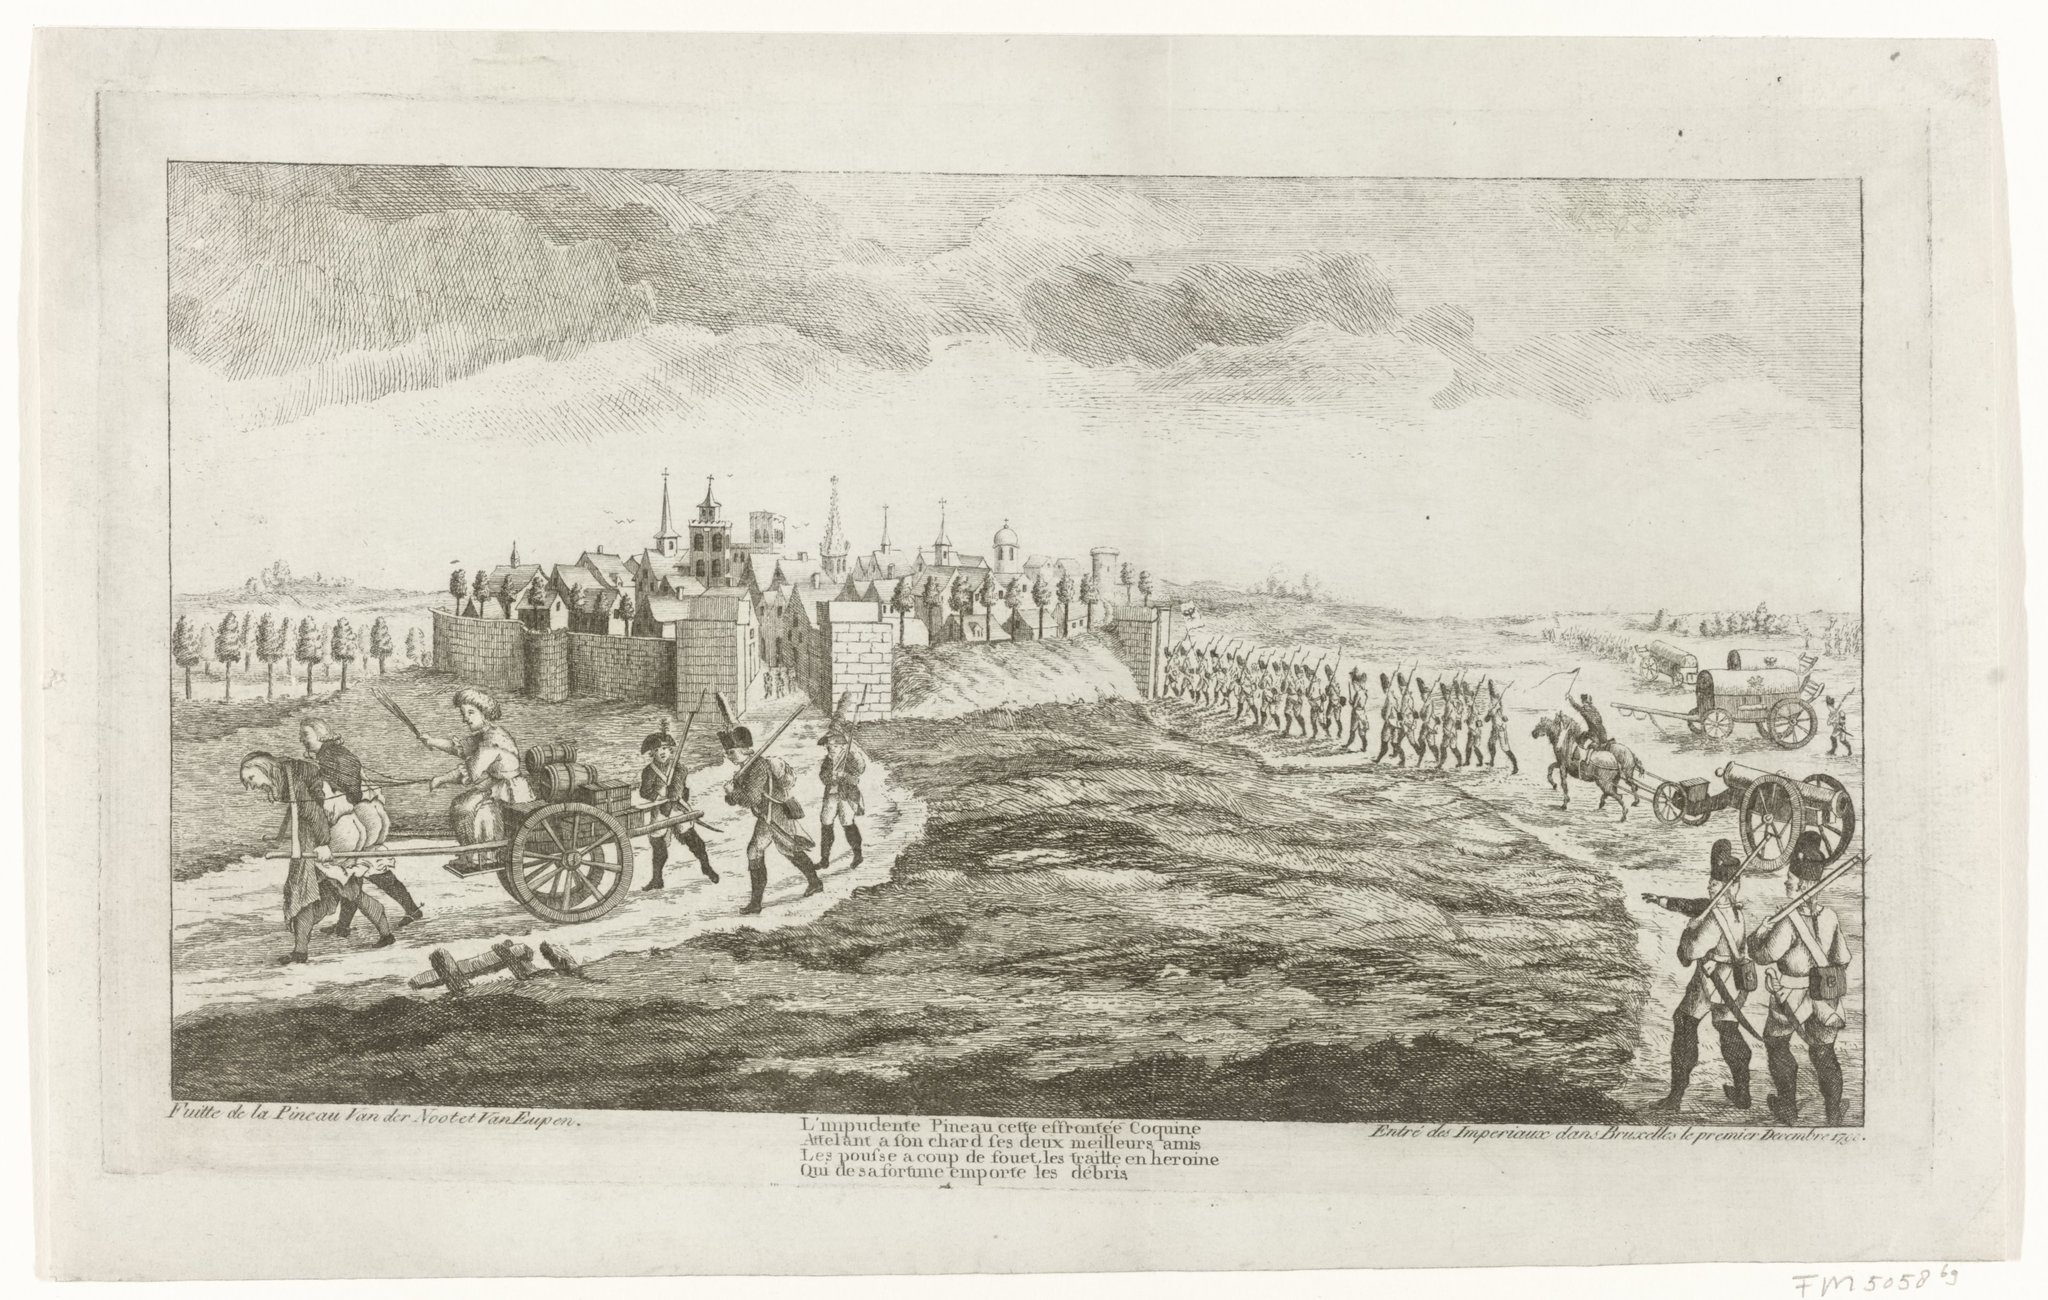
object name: cartoon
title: Fuitte de la Pineau Van der Noot et Van Eupen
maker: Anonymous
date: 1790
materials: paper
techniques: engraving, etching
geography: brussels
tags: brussels, politician, antwerp, priest, brabant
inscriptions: collector's mark: Lugt 2228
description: Spotprent waarin Hendrik van der Noot en Petrus van Eupen met blote billen de kar trekken waarin Madame Pinau (Pineau) rijdt. Rechts trekken keizerlijke troepen de stad Brussel binnen. Met vierreglig Frans vers. Onderdeel van een grote groep van prenten betrekking hebbend op de gebeurtenissen van de Brabantse Omwenteling en de periode 1787-1790.